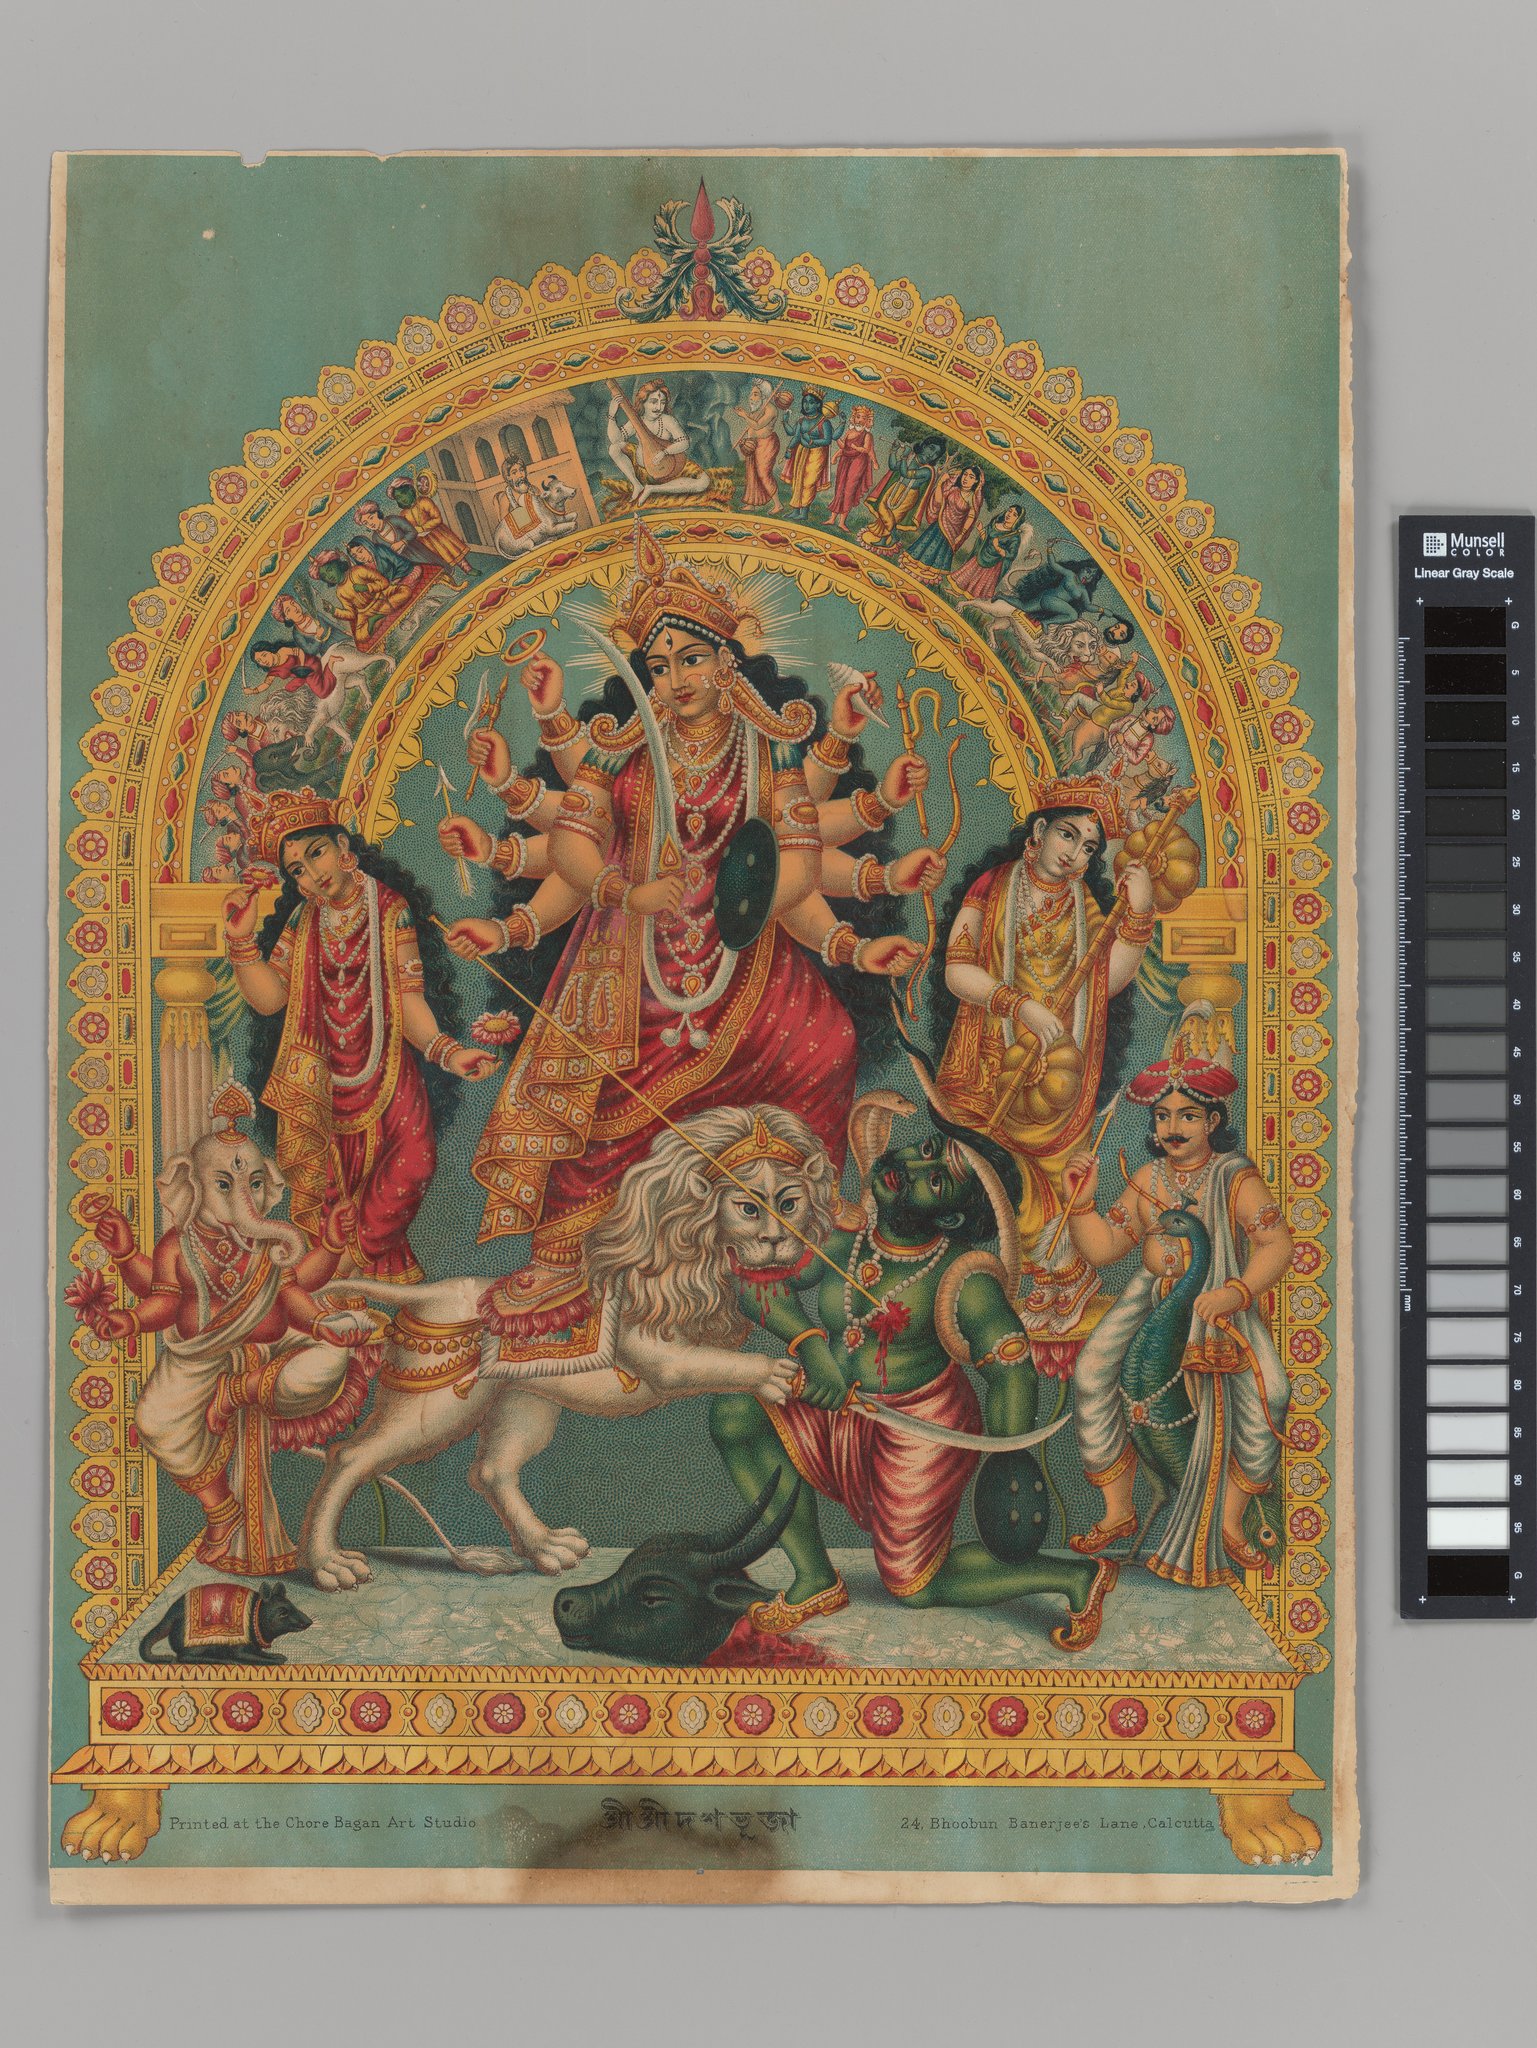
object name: print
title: Shri Shri Durga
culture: indian or west bengali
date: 1885-1895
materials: chromolithograph, paper